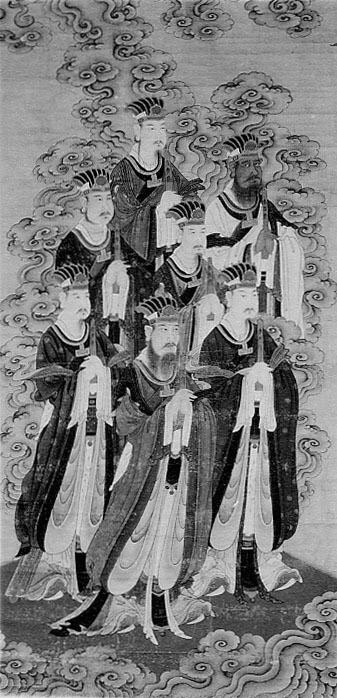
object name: hanging scroll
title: Seven Heavenly Kings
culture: chinese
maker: unidentified artist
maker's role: artist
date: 1368-1911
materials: silk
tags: kings,men